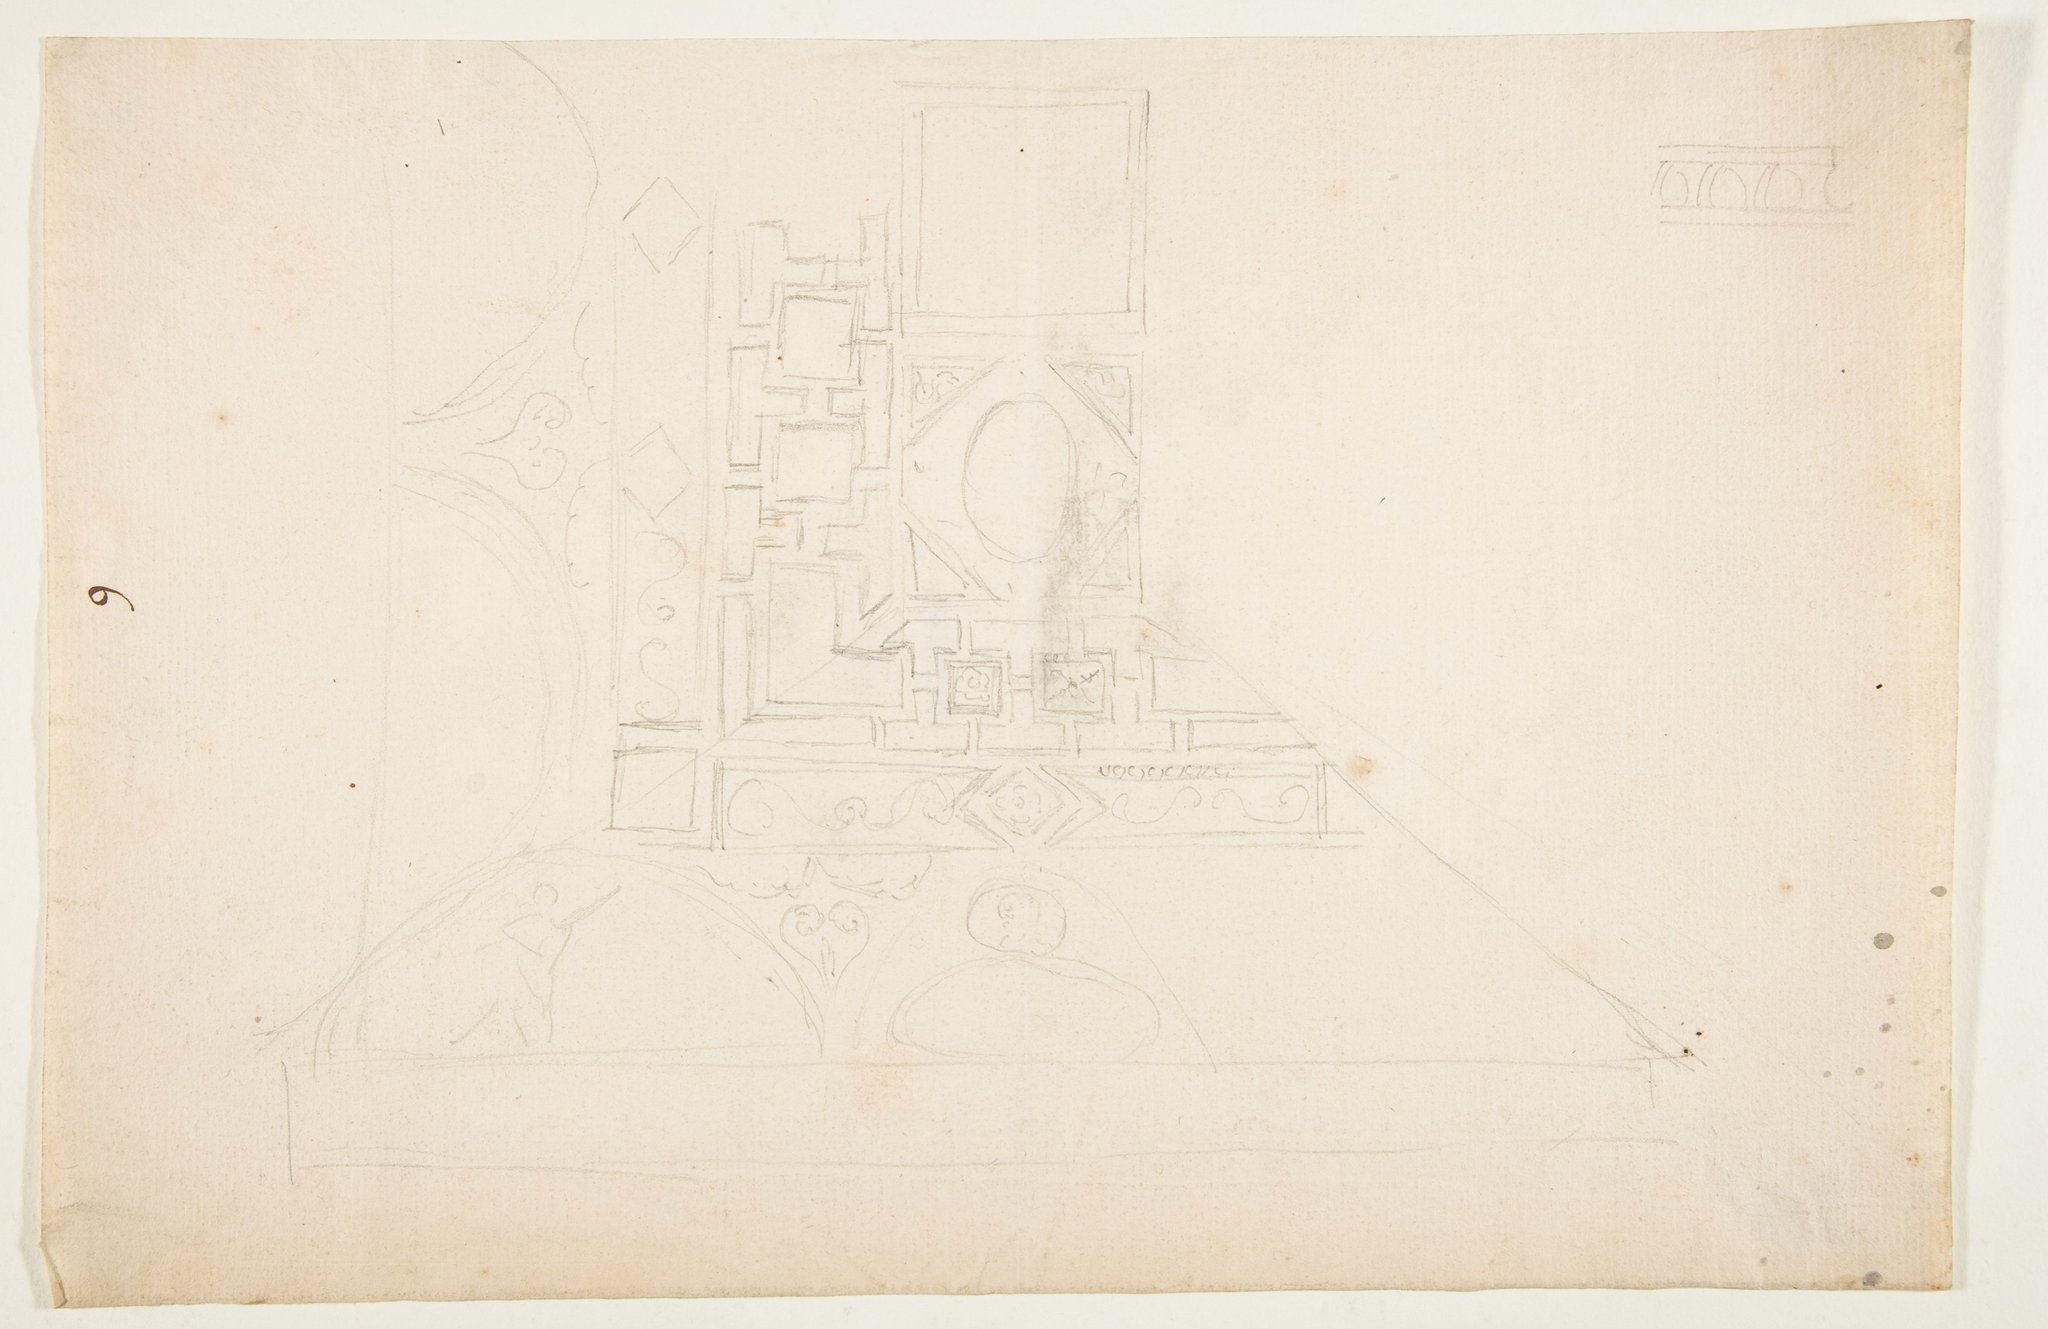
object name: drawing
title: Drawing After and Architectural Fragment of a Coffered Ceiling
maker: anonymous, french, 19th century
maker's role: artist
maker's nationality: french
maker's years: 1800-1900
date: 1801-1900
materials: graphite